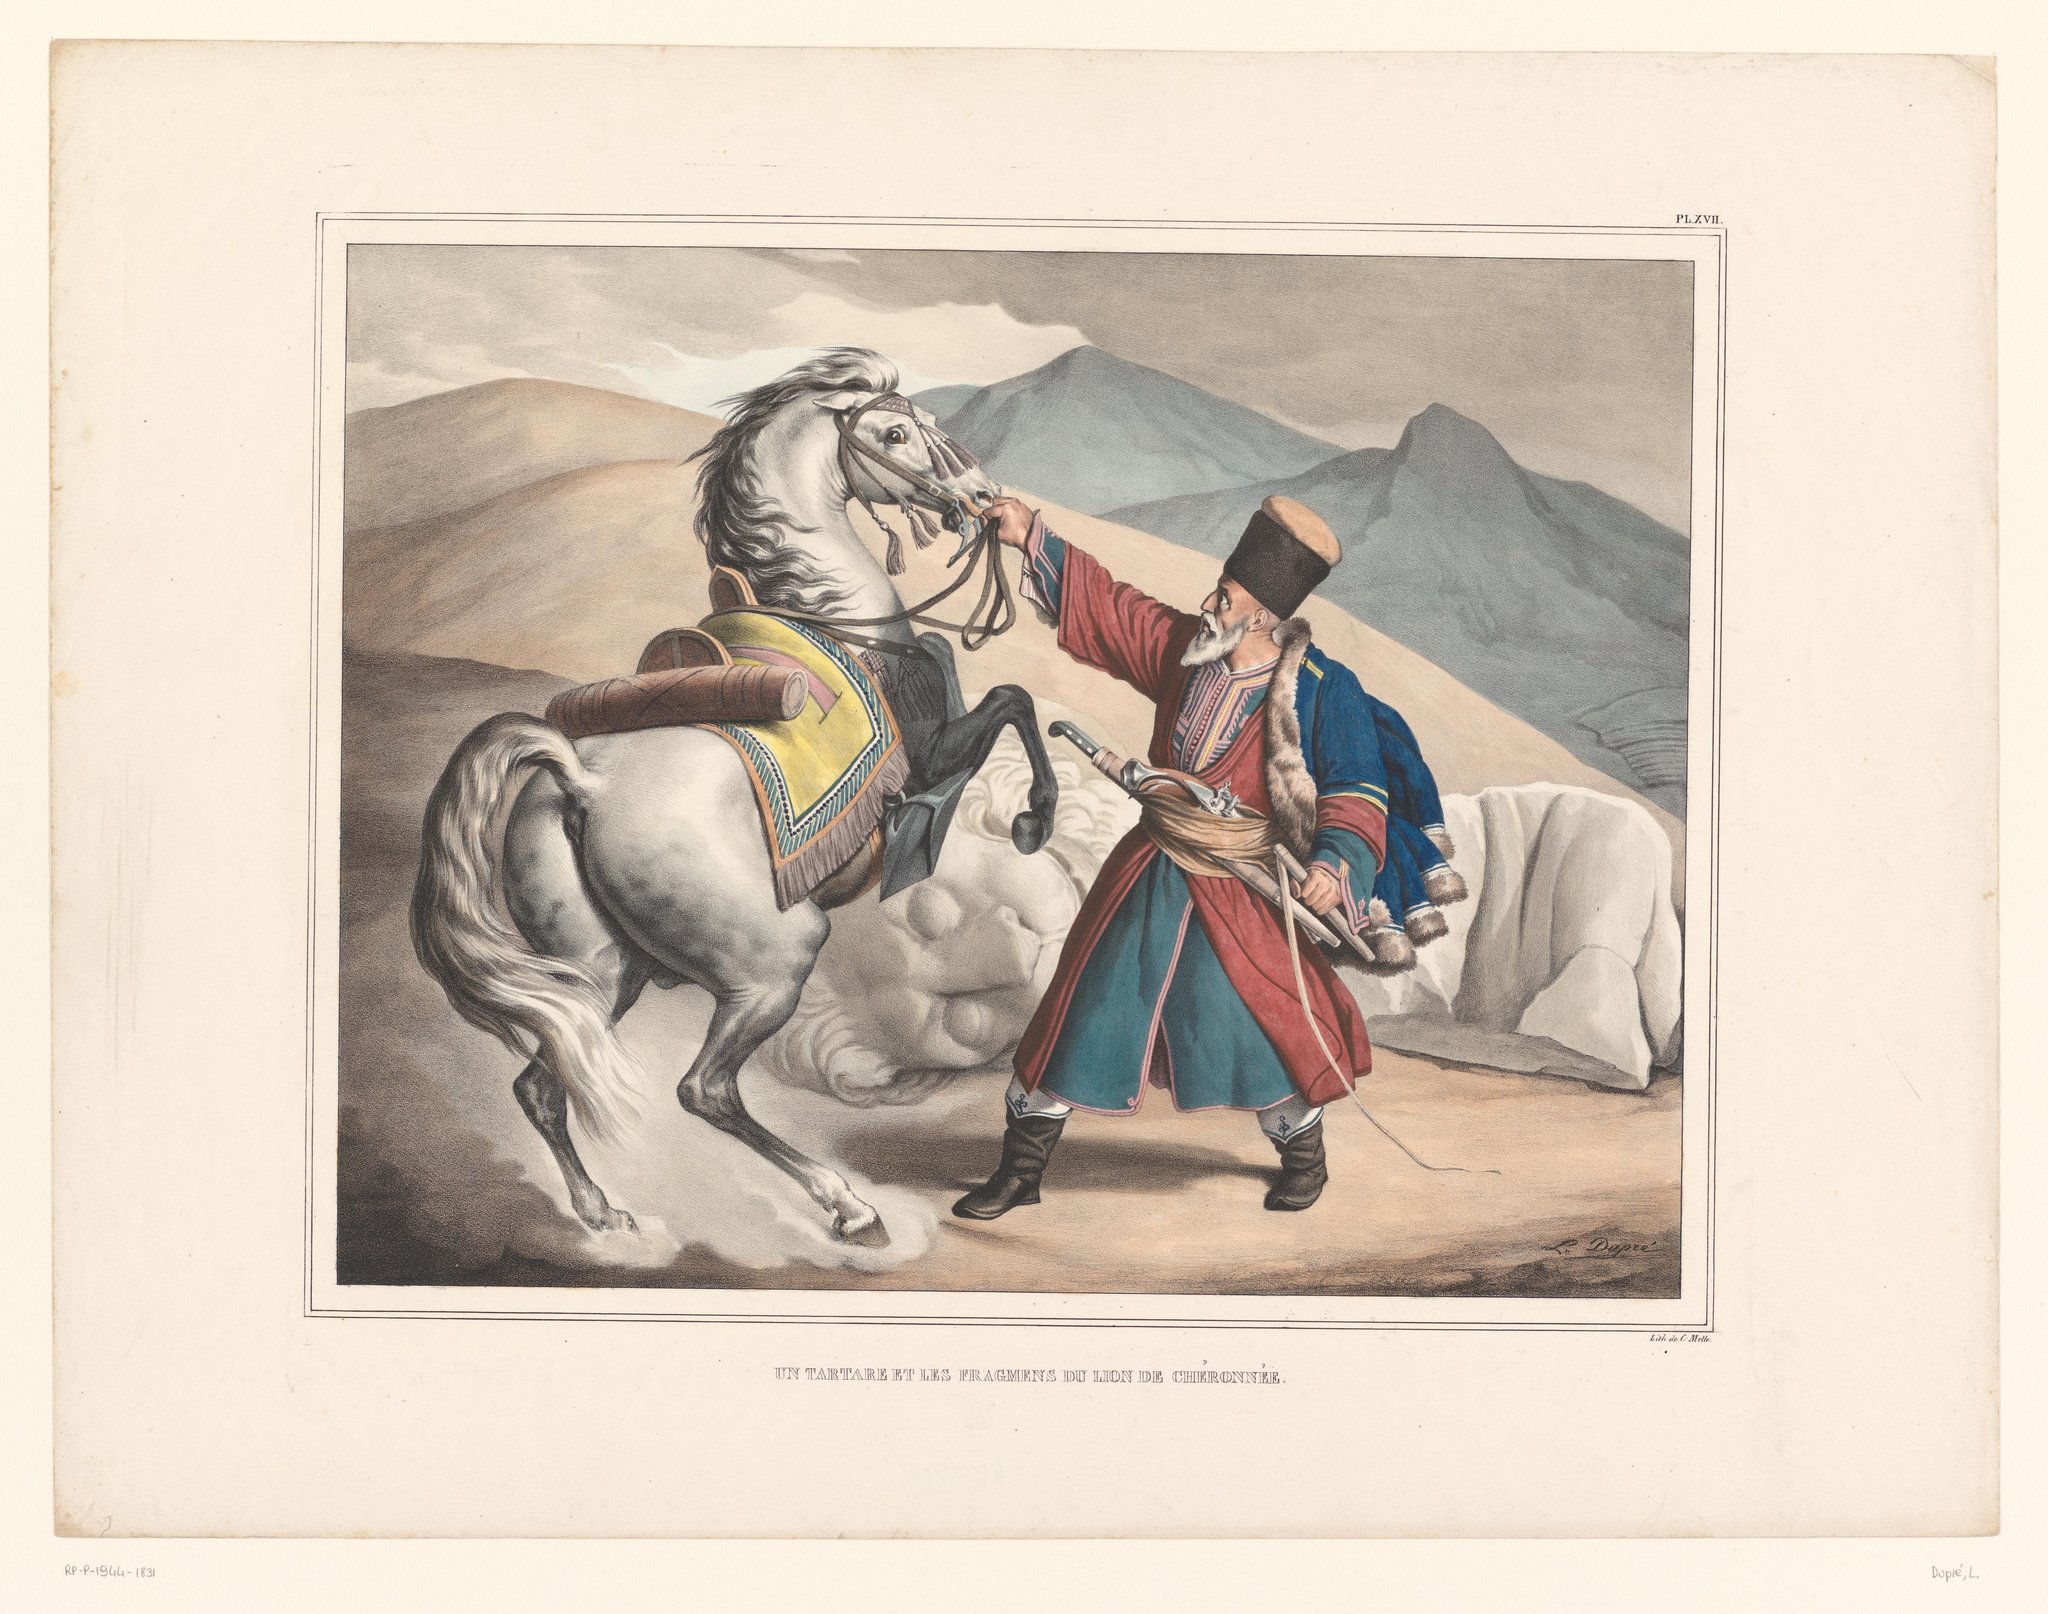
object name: print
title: Voyage à Athènes et à Constantinople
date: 1825-1837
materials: paper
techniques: hand coloring, lithograph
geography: paris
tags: riding a horse, ass, or mule; rider, horseman, monumental adornments (in city), asiatic races and peoples (tatars)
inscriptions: check stamp: ‘LD’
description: De prent maakt deel uit van de serie 'Voyage à Athènes et à Constantinople ou collection de portraits, de vues et de costumes Grecs et Ottomans' die tussen 1825 en 1839 in tien delen van vier prenten werd uitgebracht. De in totaal veertig prenten dienden samen met een tekst van 52 pagina's voorzien van vignettes als een verslag van de reis die Louis Dupré in 1819 naar Athene en het huidige Istanboel maakte (zie documentatie).